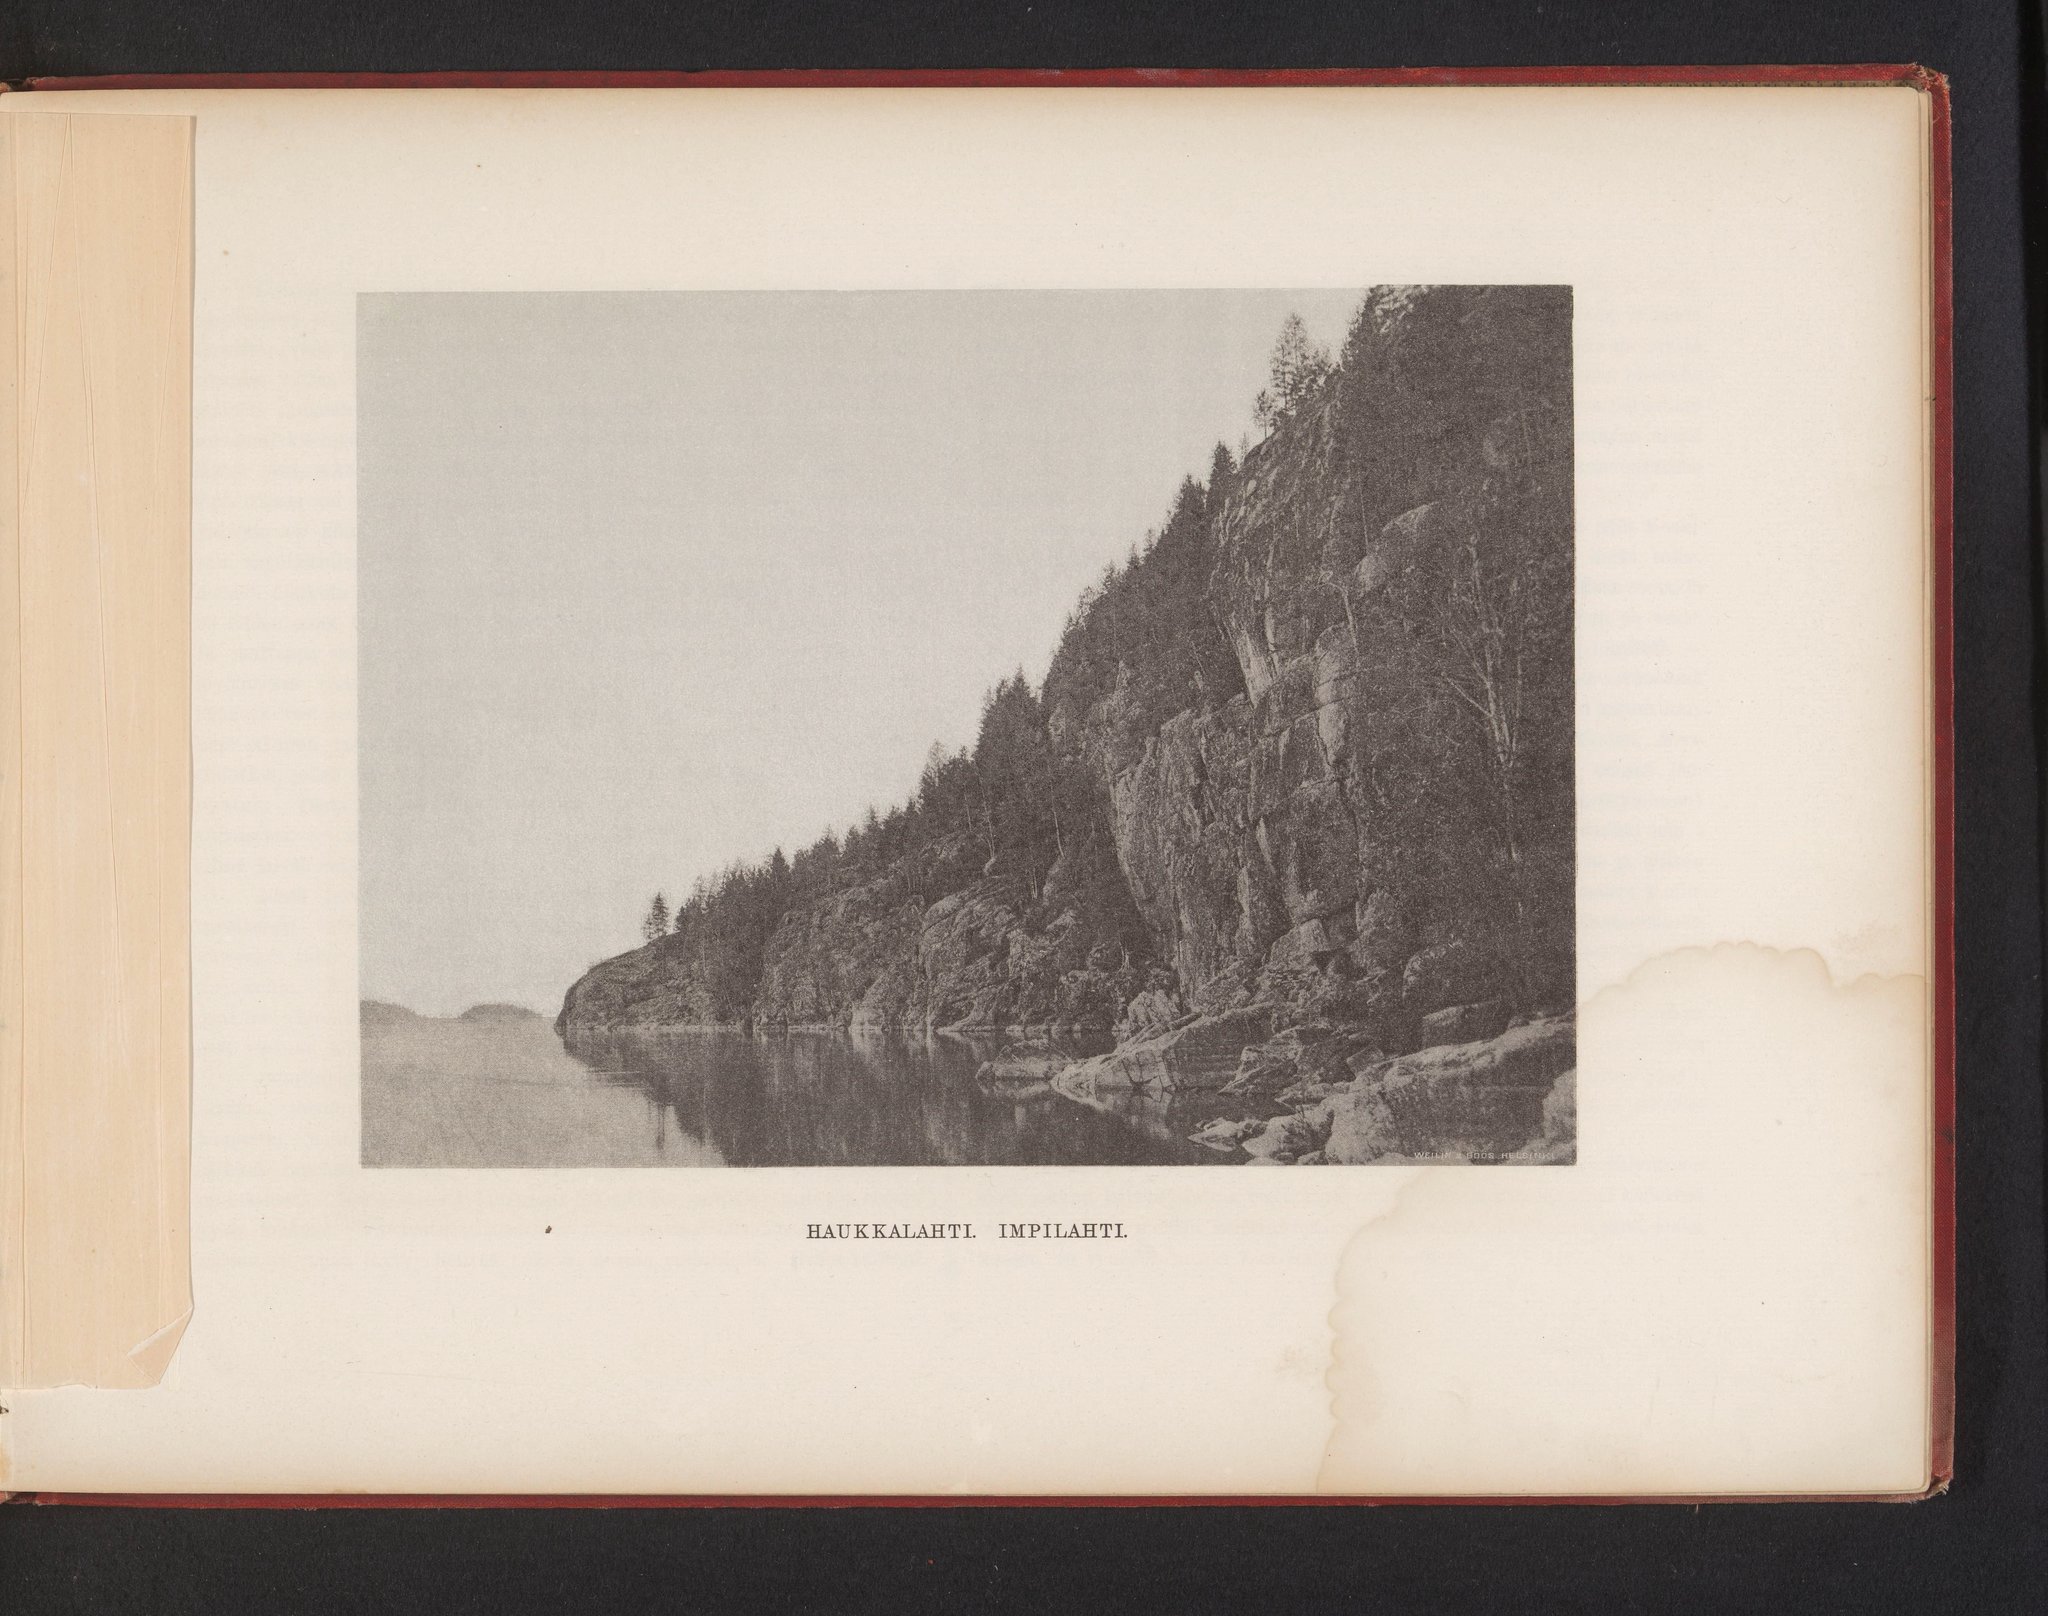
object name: photomechanical print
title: Haukkalahti. impilahti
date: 1888-1893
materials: paper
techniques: autotype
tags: trees, landscapes with waters, waterscapes, seascapes (in the temperate zone), rocks